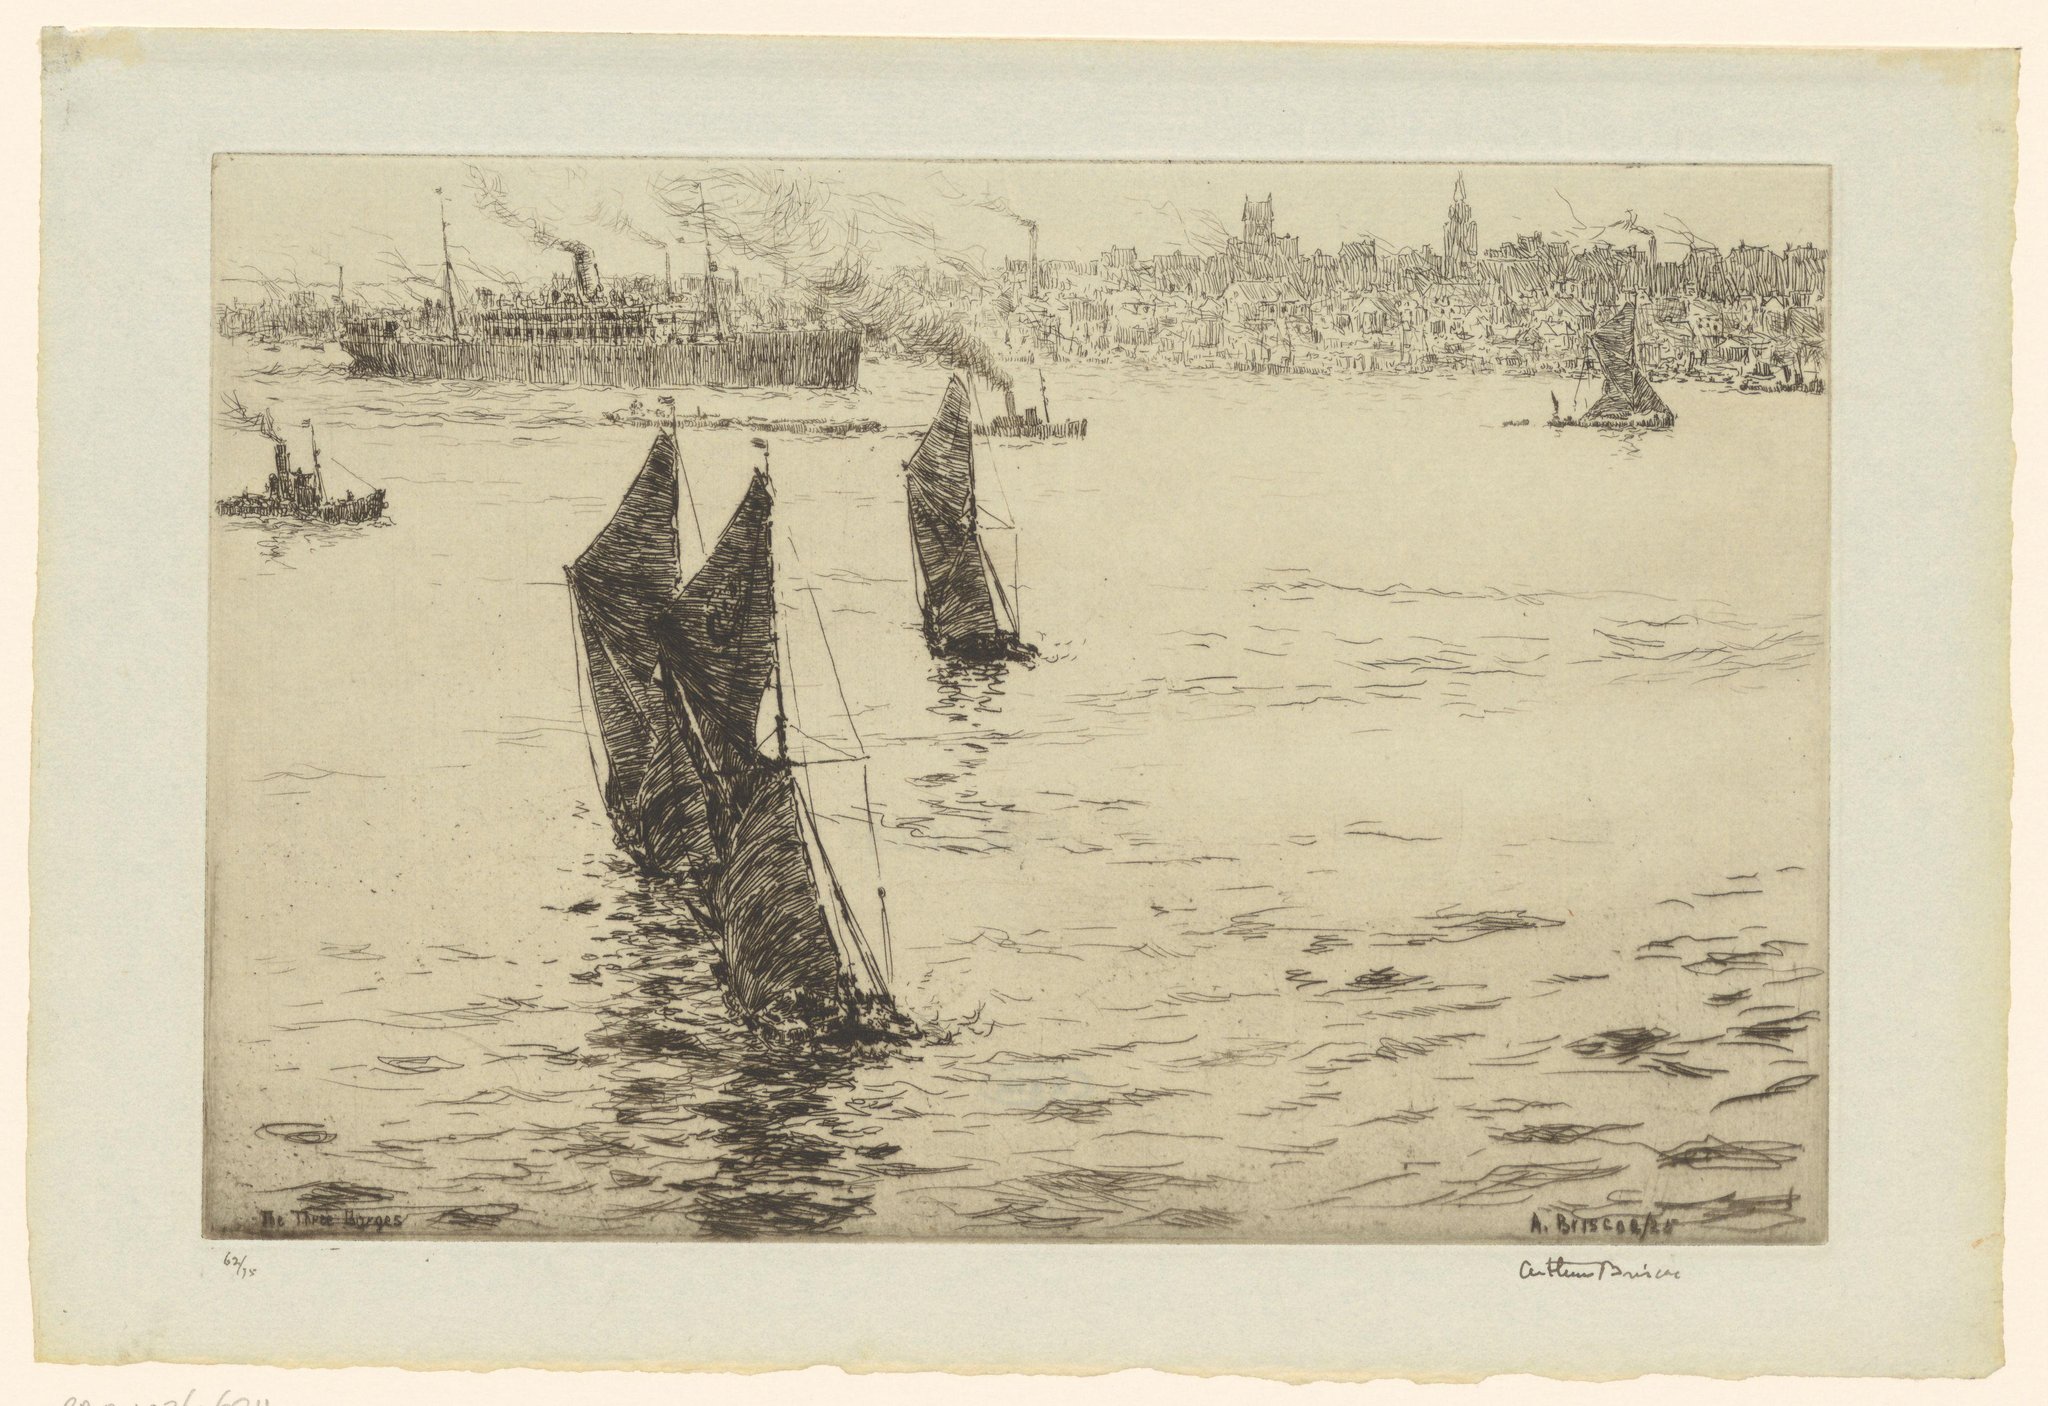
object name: print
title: Boten en schepen varend langs een stad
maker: arthur john trevor briscoe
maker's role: print maker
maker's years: 1873-1943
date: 1925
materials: paper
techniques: drypoint, etching, intaglio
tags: sailing-ship, sailing-boat, ships (in general) - cc - more than one ship, prospect of city, town panorama, silhouette of city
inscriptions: collector's mark: Lugt 2228